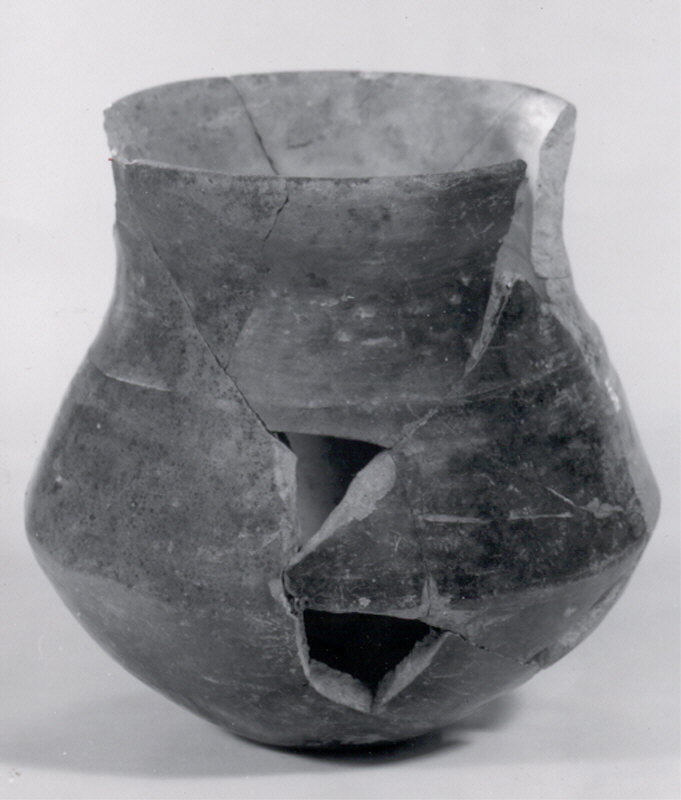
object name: jar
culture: iranian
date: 900-801 BCE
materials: ceramic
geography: iran